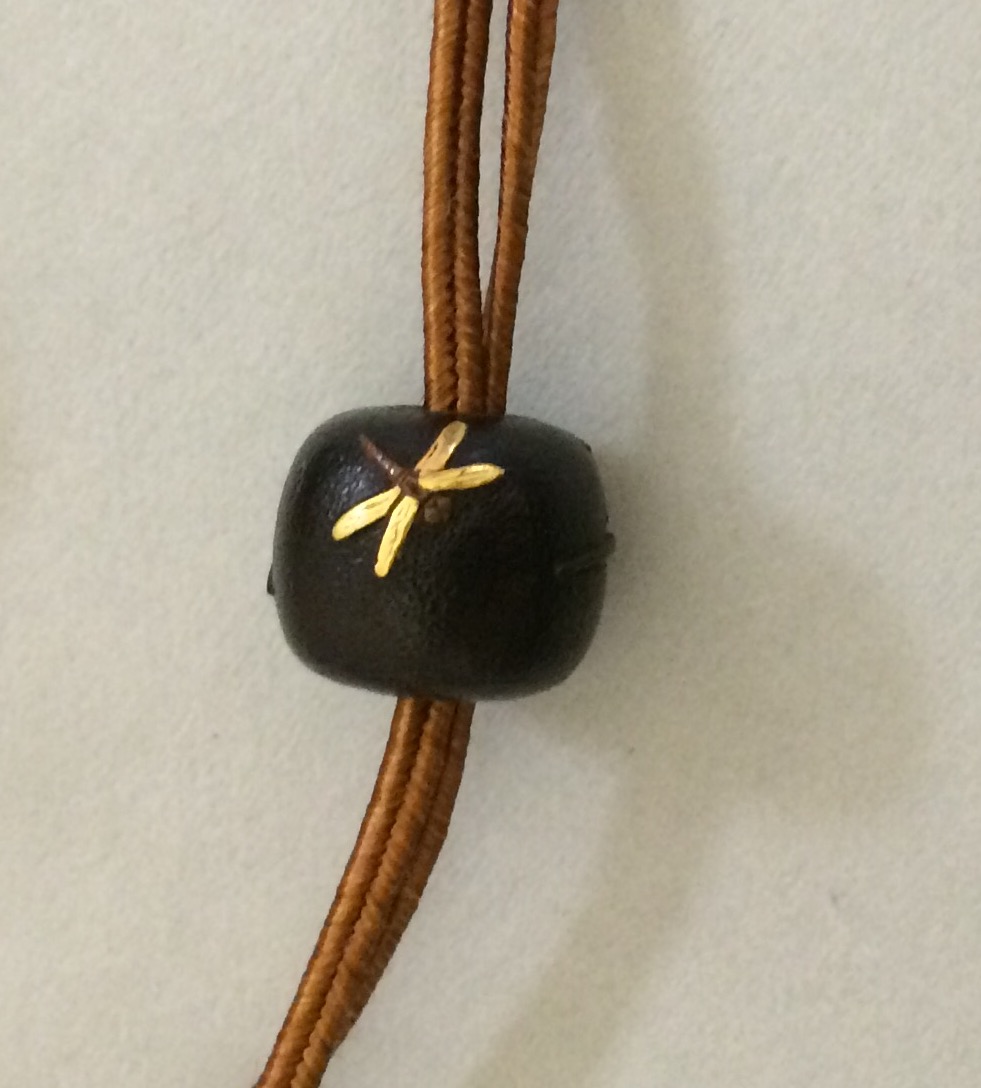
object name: ojime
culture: japanese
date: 1801-1900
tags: dragonflies